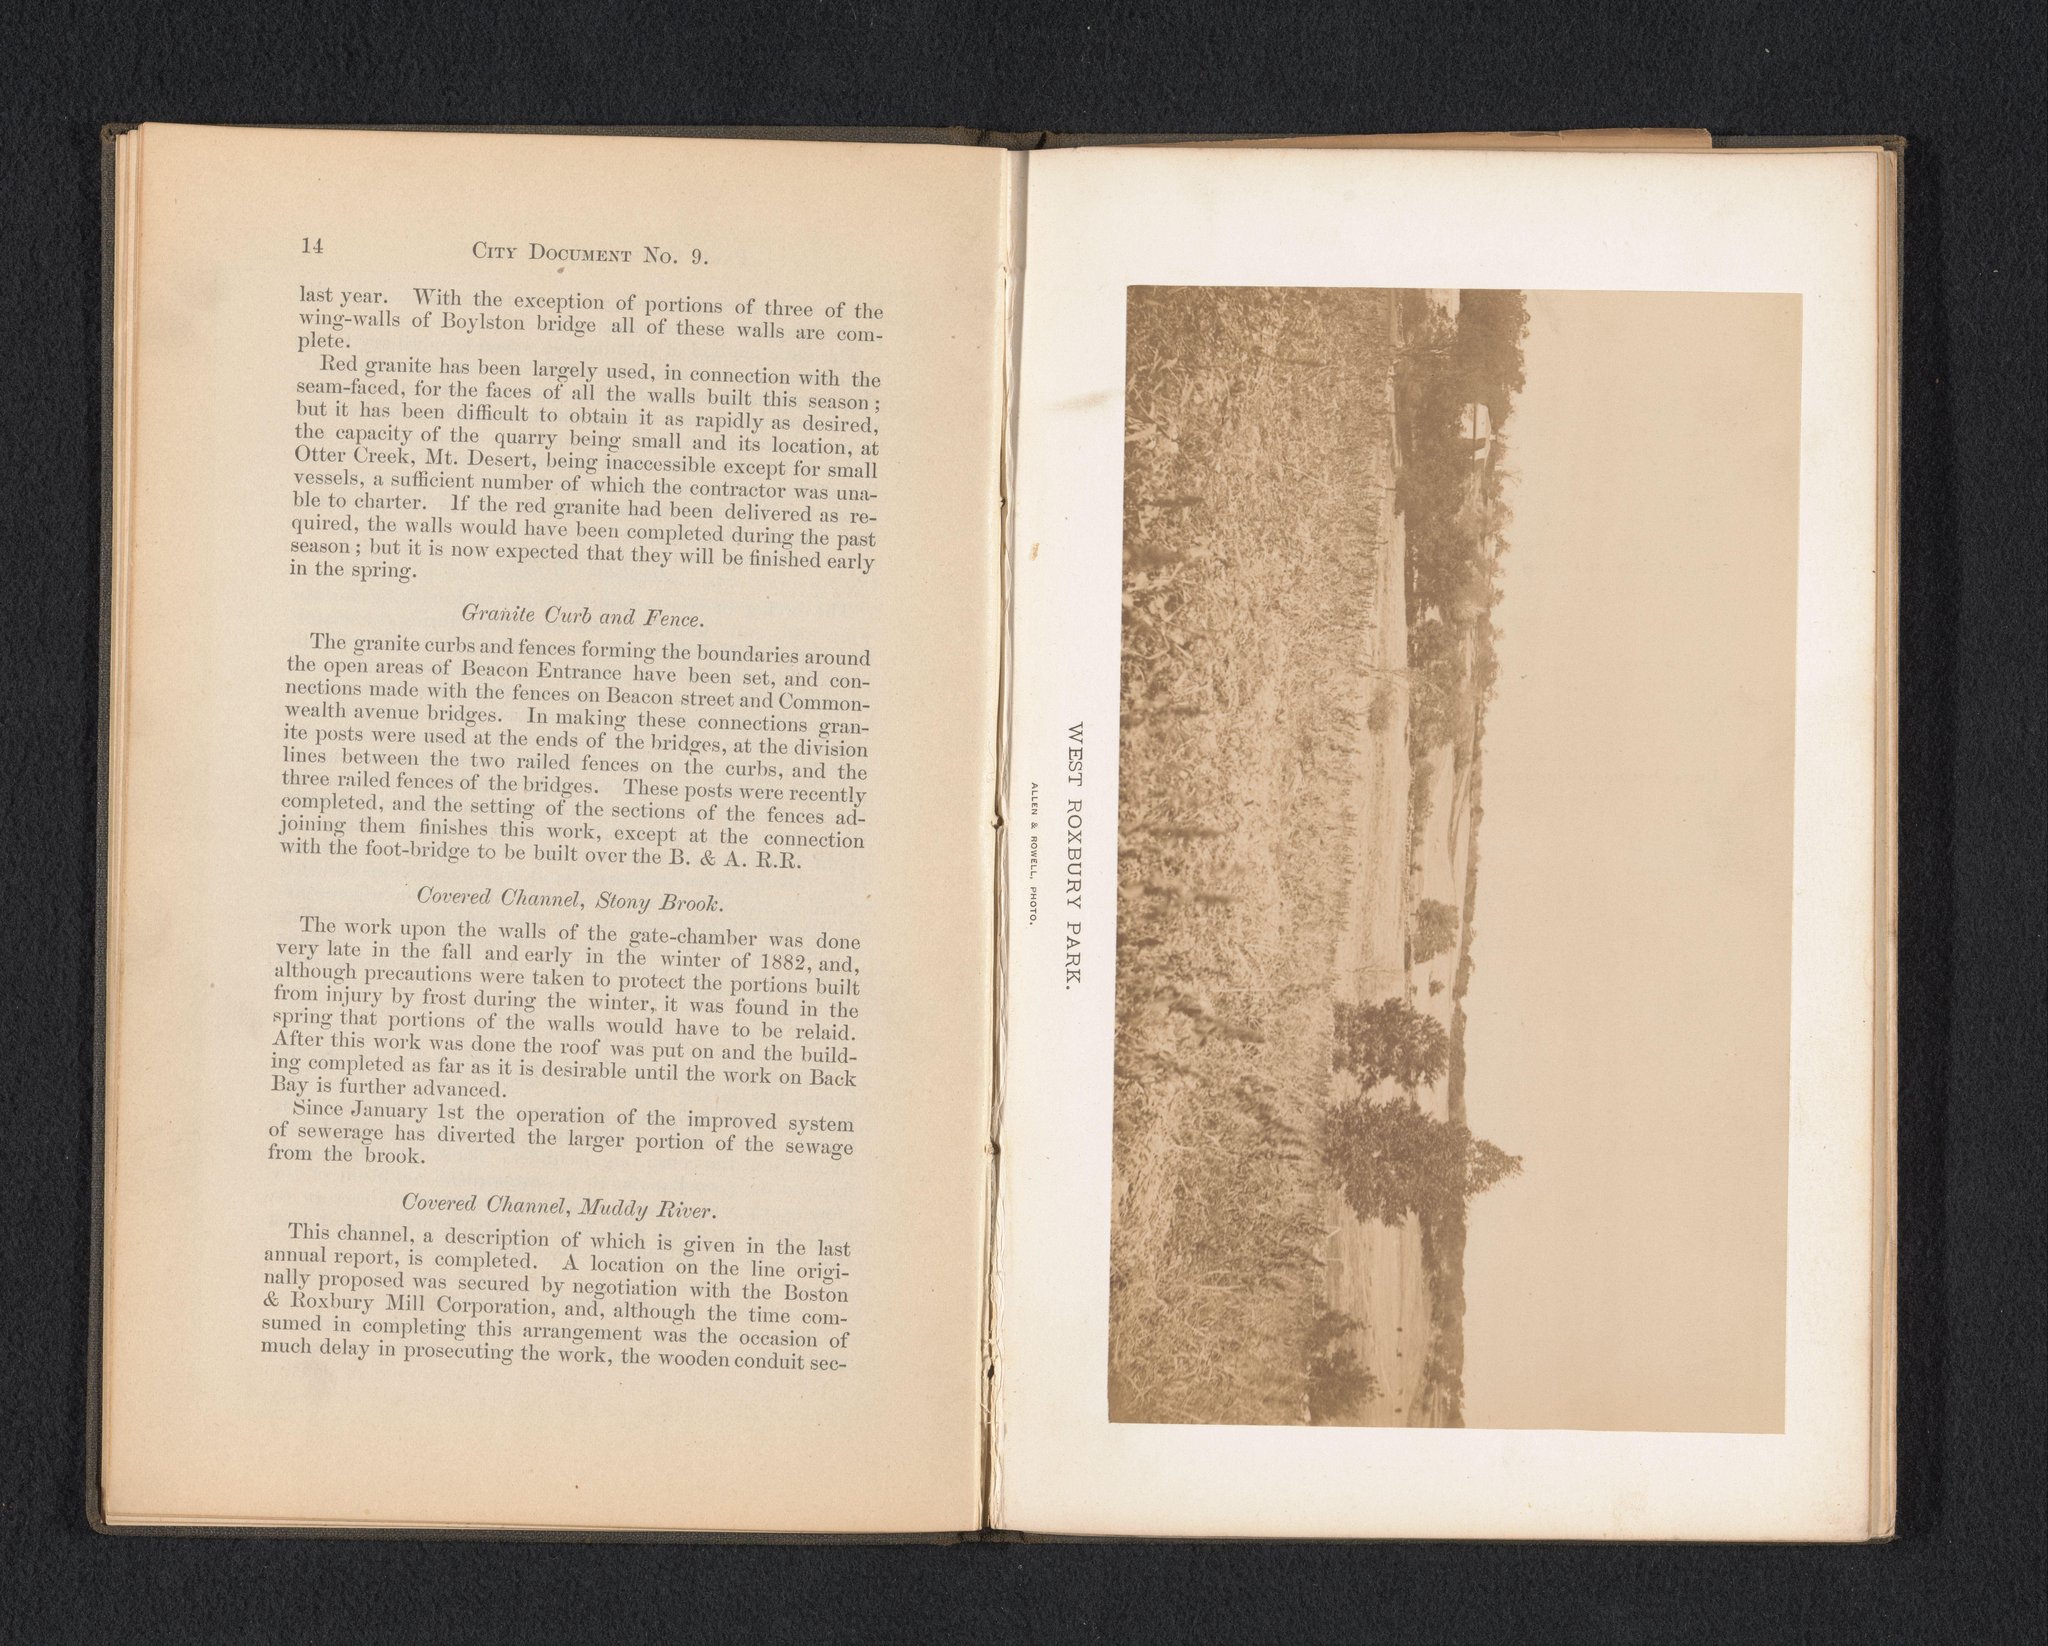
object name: page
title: West Roxbury Park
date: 1878-1883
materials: photographic support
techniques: albumen print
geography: boston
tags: public gardens, park